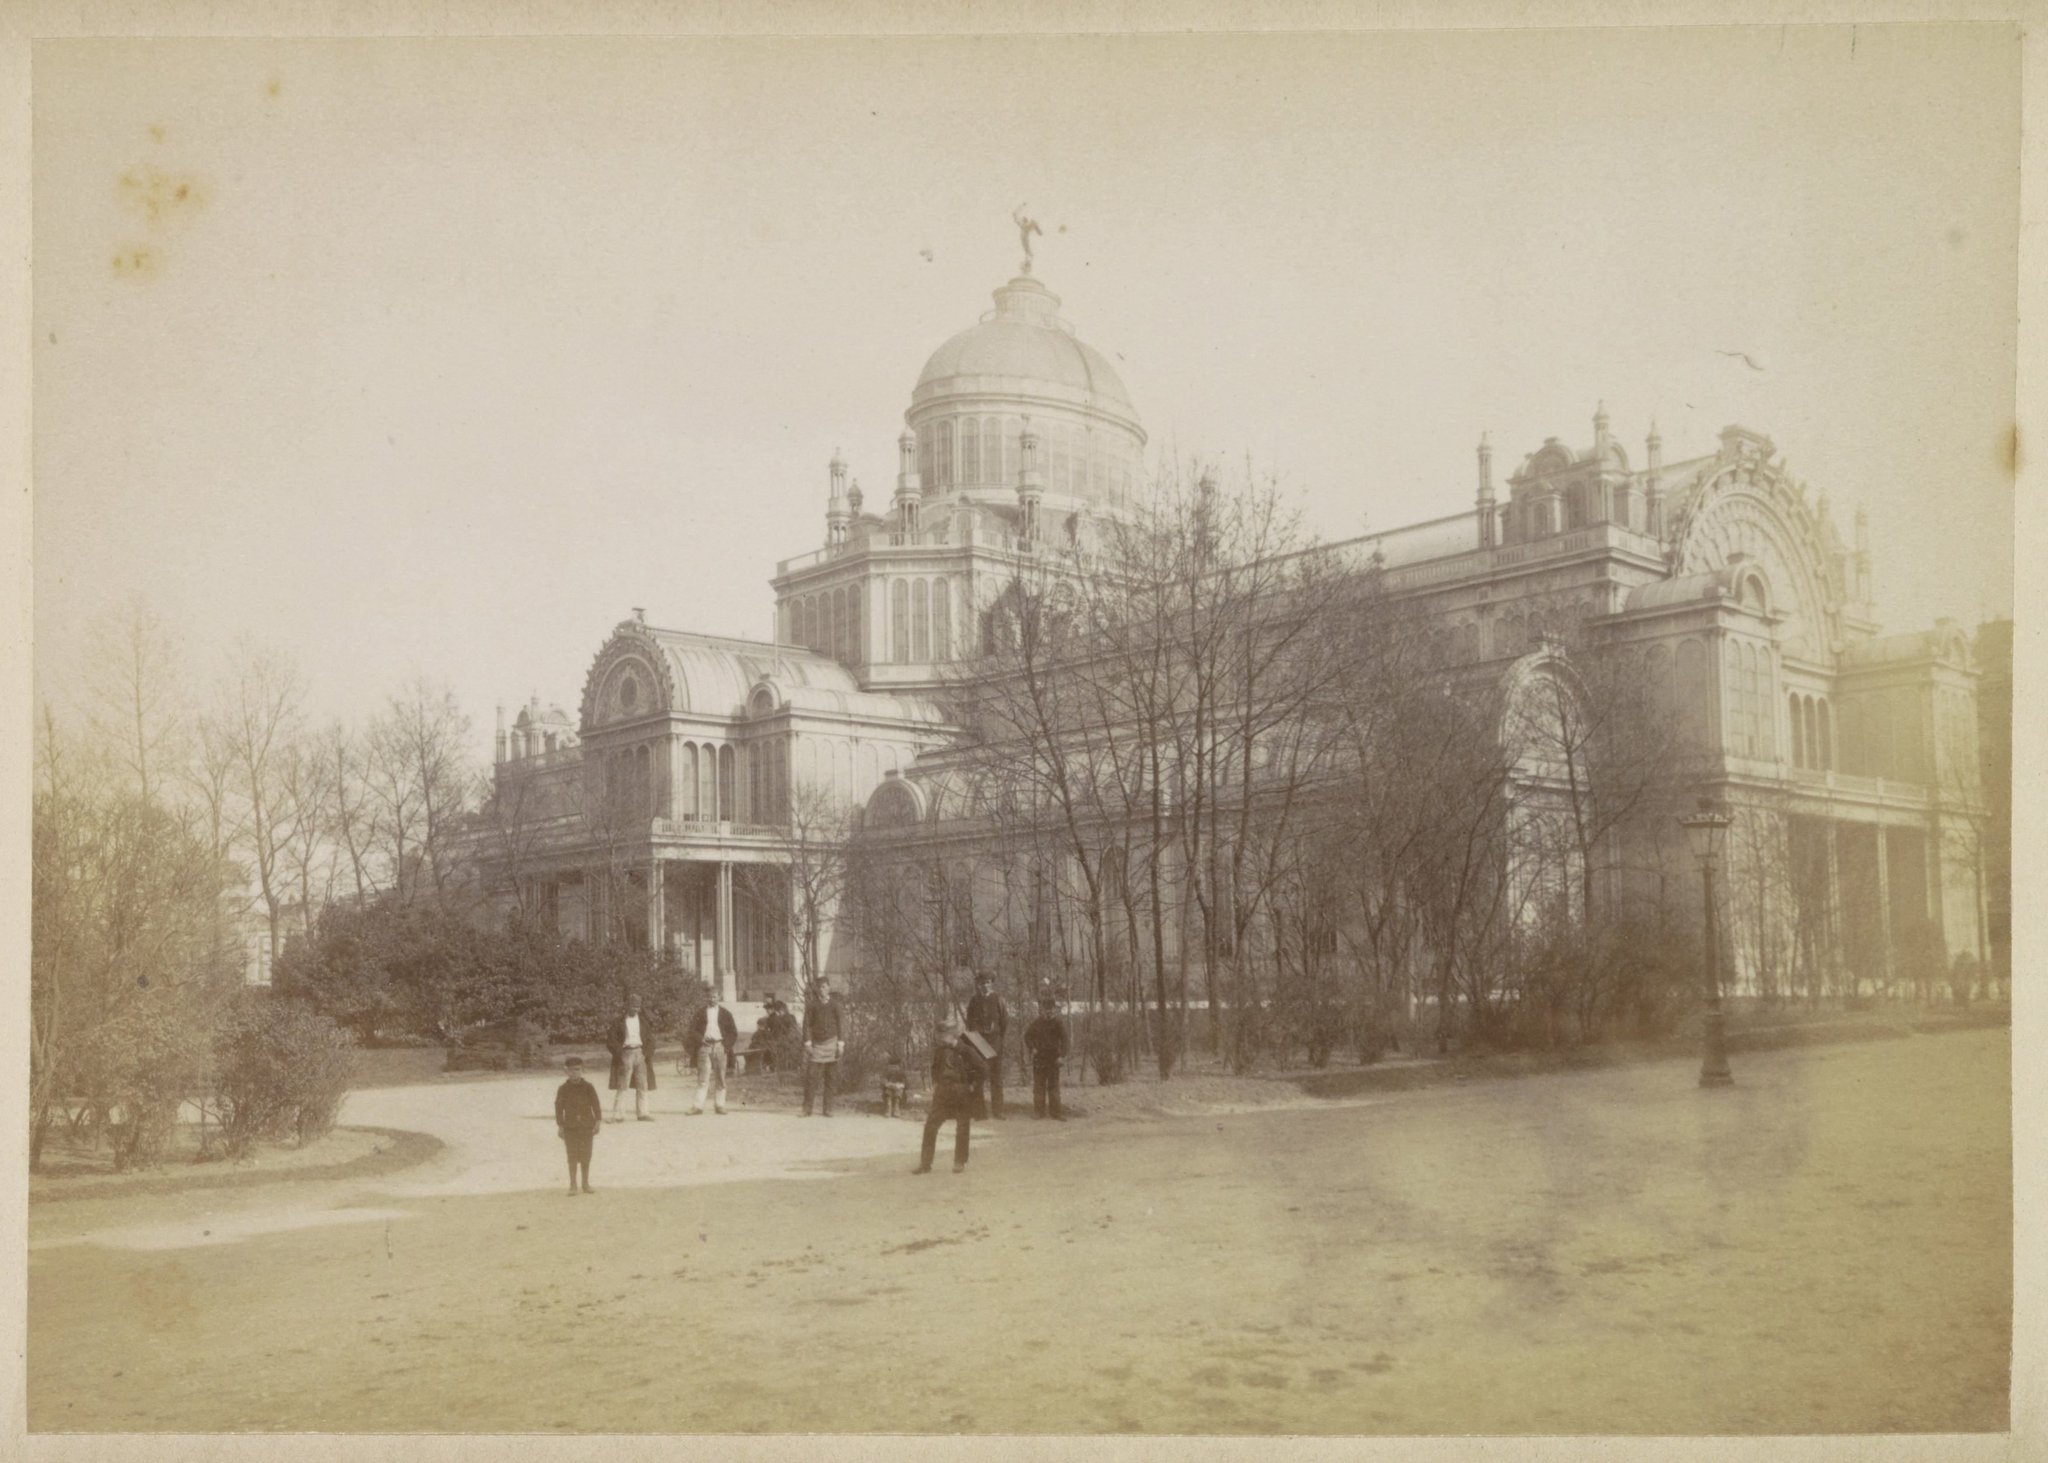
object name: photograph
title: Het Paleis voor Volksvlijt. Amsterdam.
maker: andries jager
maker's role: publisher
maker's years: 1825-1905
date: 1860-1900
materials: cardboard, photographic support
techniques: albumen print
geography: amsterdam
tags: palace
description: Onderdeel van Leporelloalbum met 24 foto's van Amsterdam.